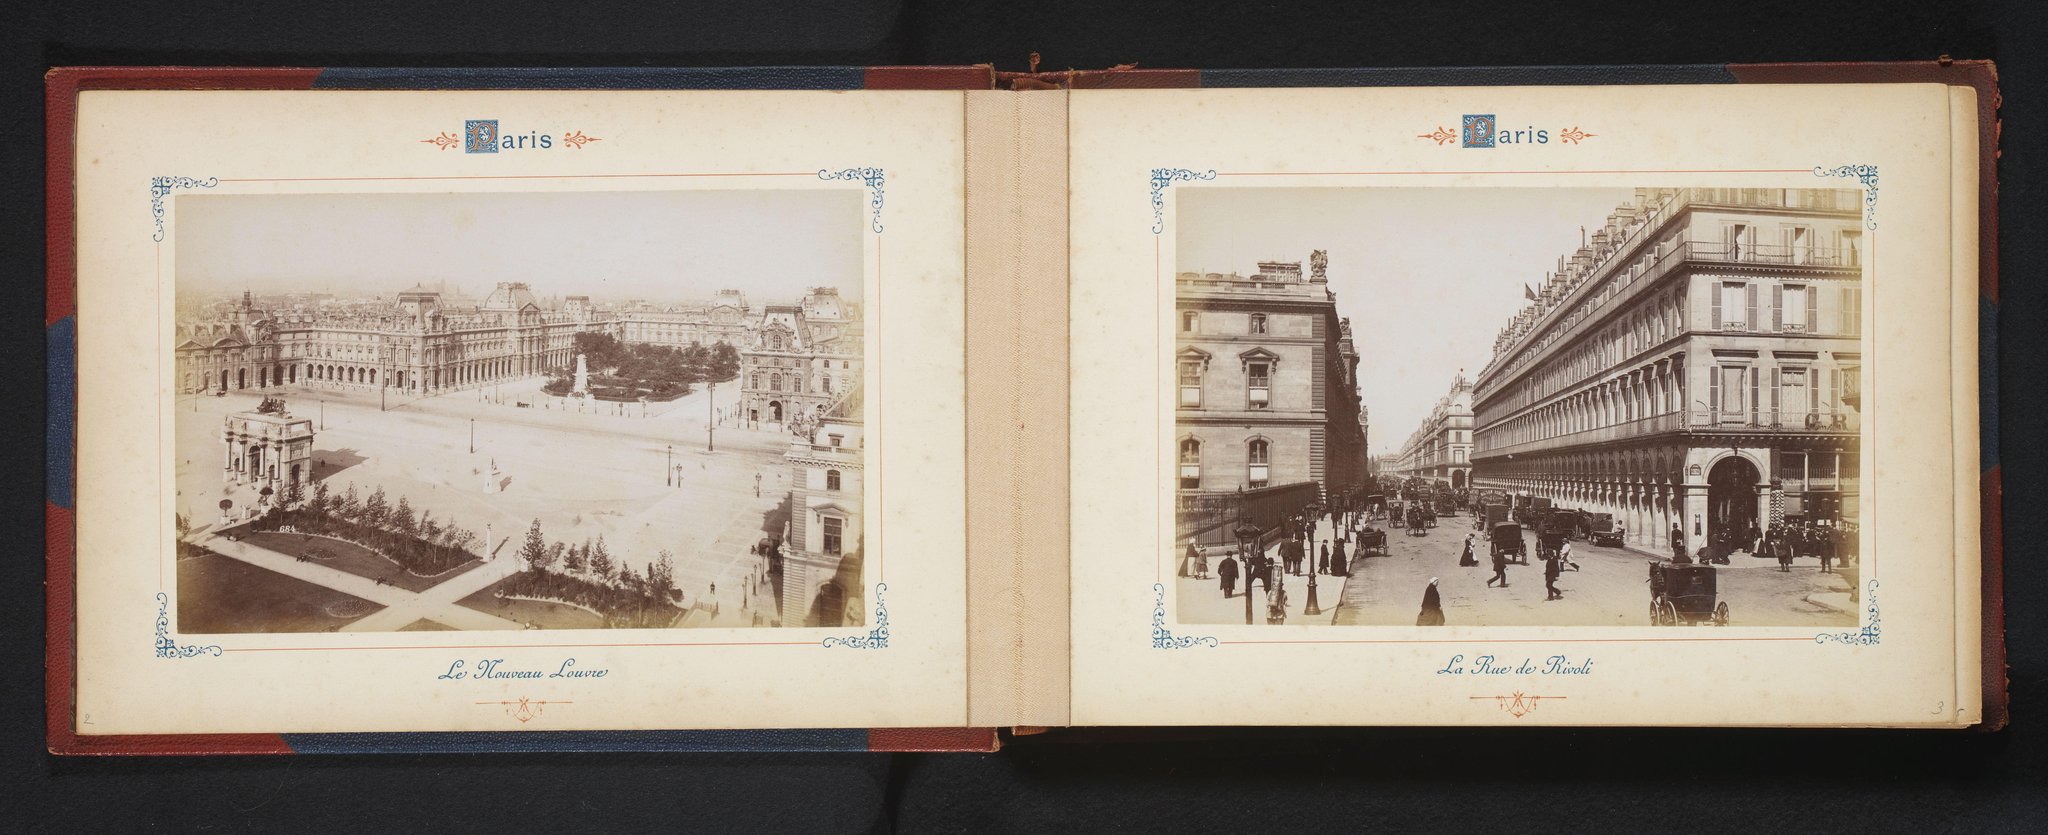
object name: page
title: Le nouveau Louvre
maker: Anonymous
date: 1879-1889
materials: photographic support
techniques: albumen print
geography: paris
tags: square, place, circus, etc., city-view in general; 'veduta'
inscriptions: number: ‘684’